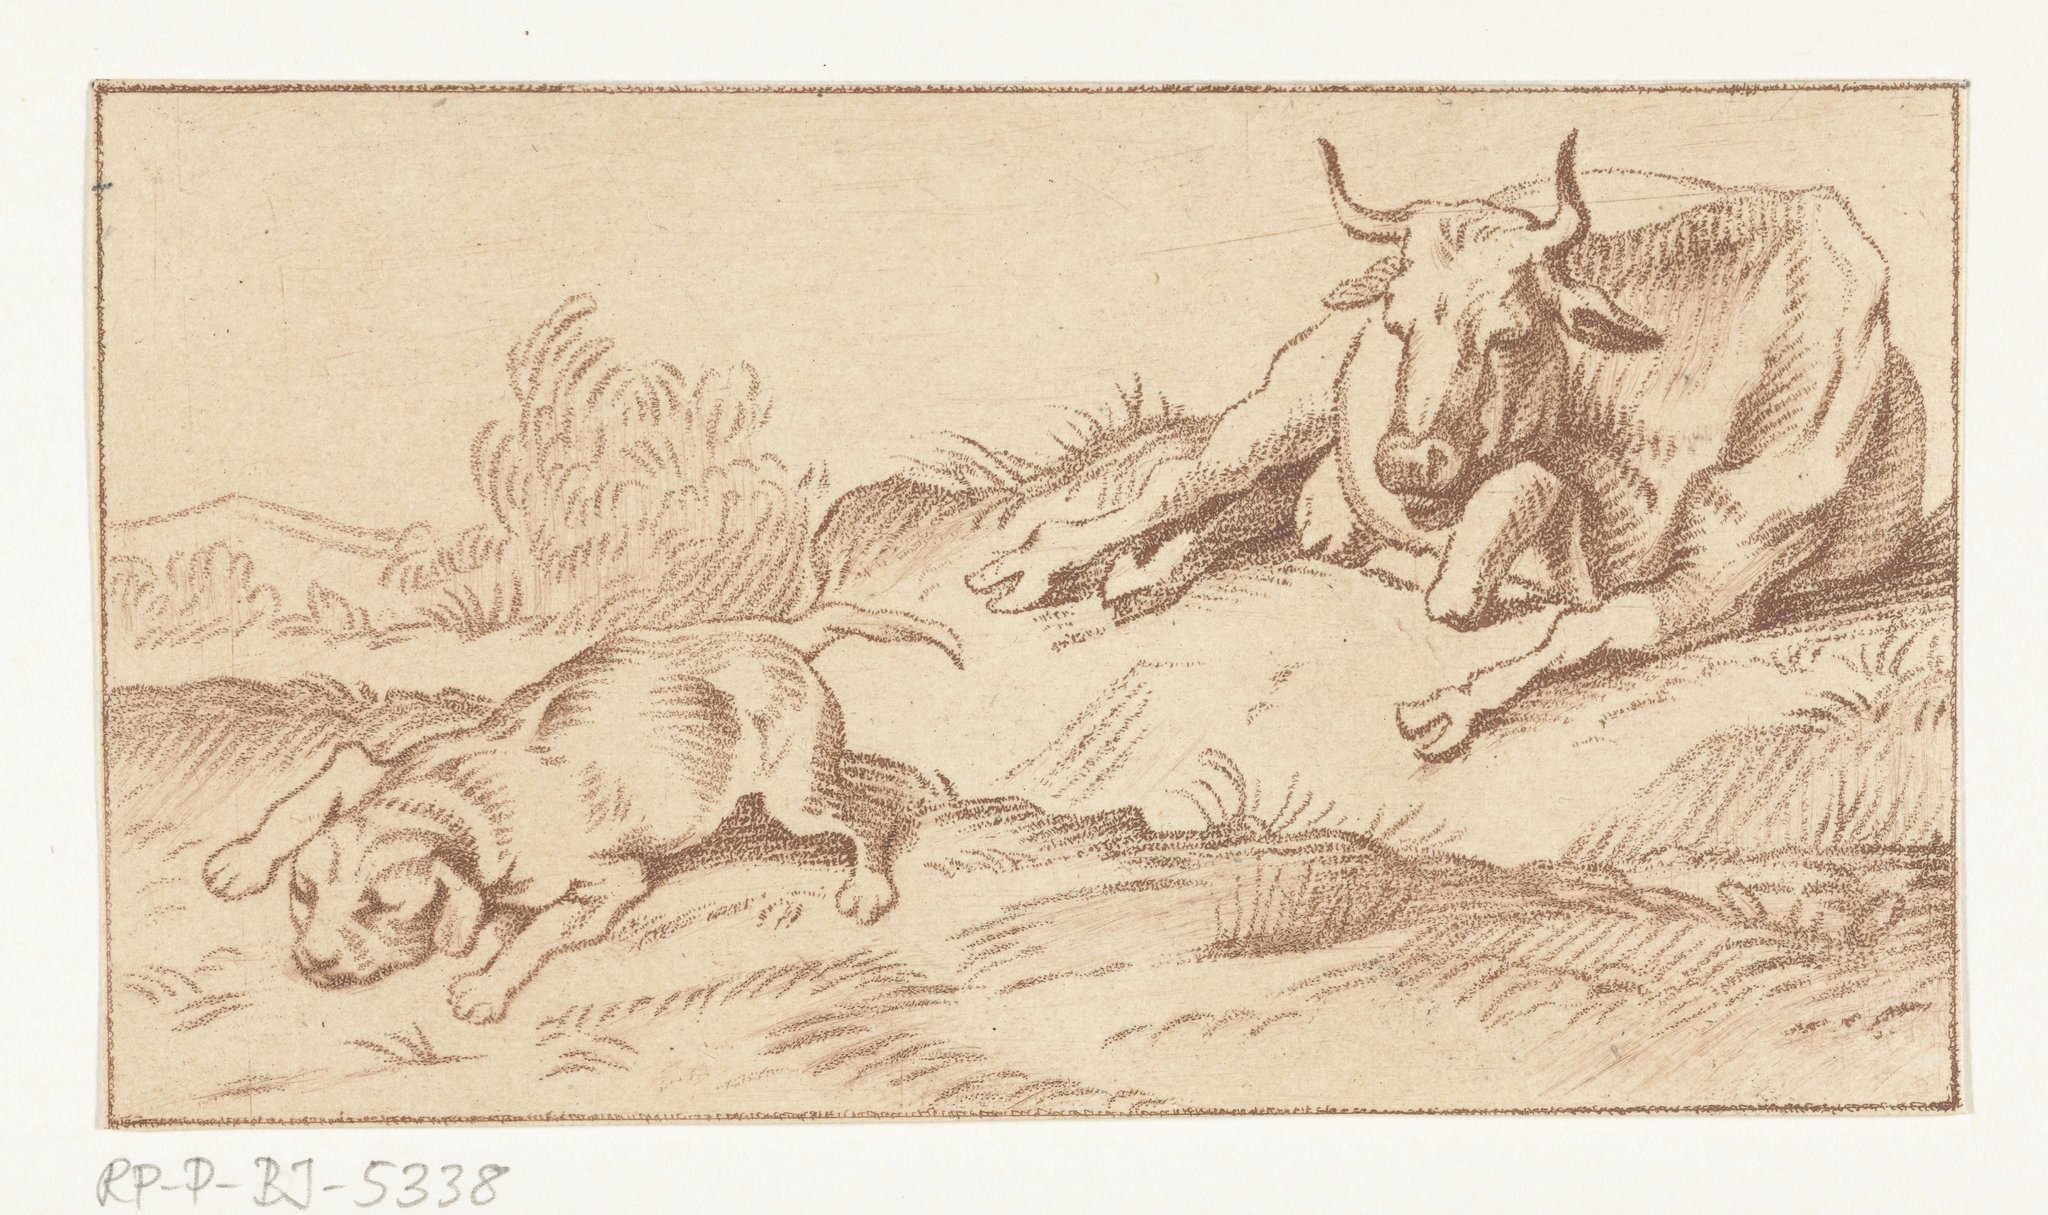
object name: print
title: Koe en hond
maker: jacobus buys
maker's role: draughtsman, print maker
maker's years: 1724-1801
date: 1740-1801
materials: paper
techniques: printmaking, etching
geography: amsterdam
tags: dog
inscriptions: collector's mark: Lugt 240